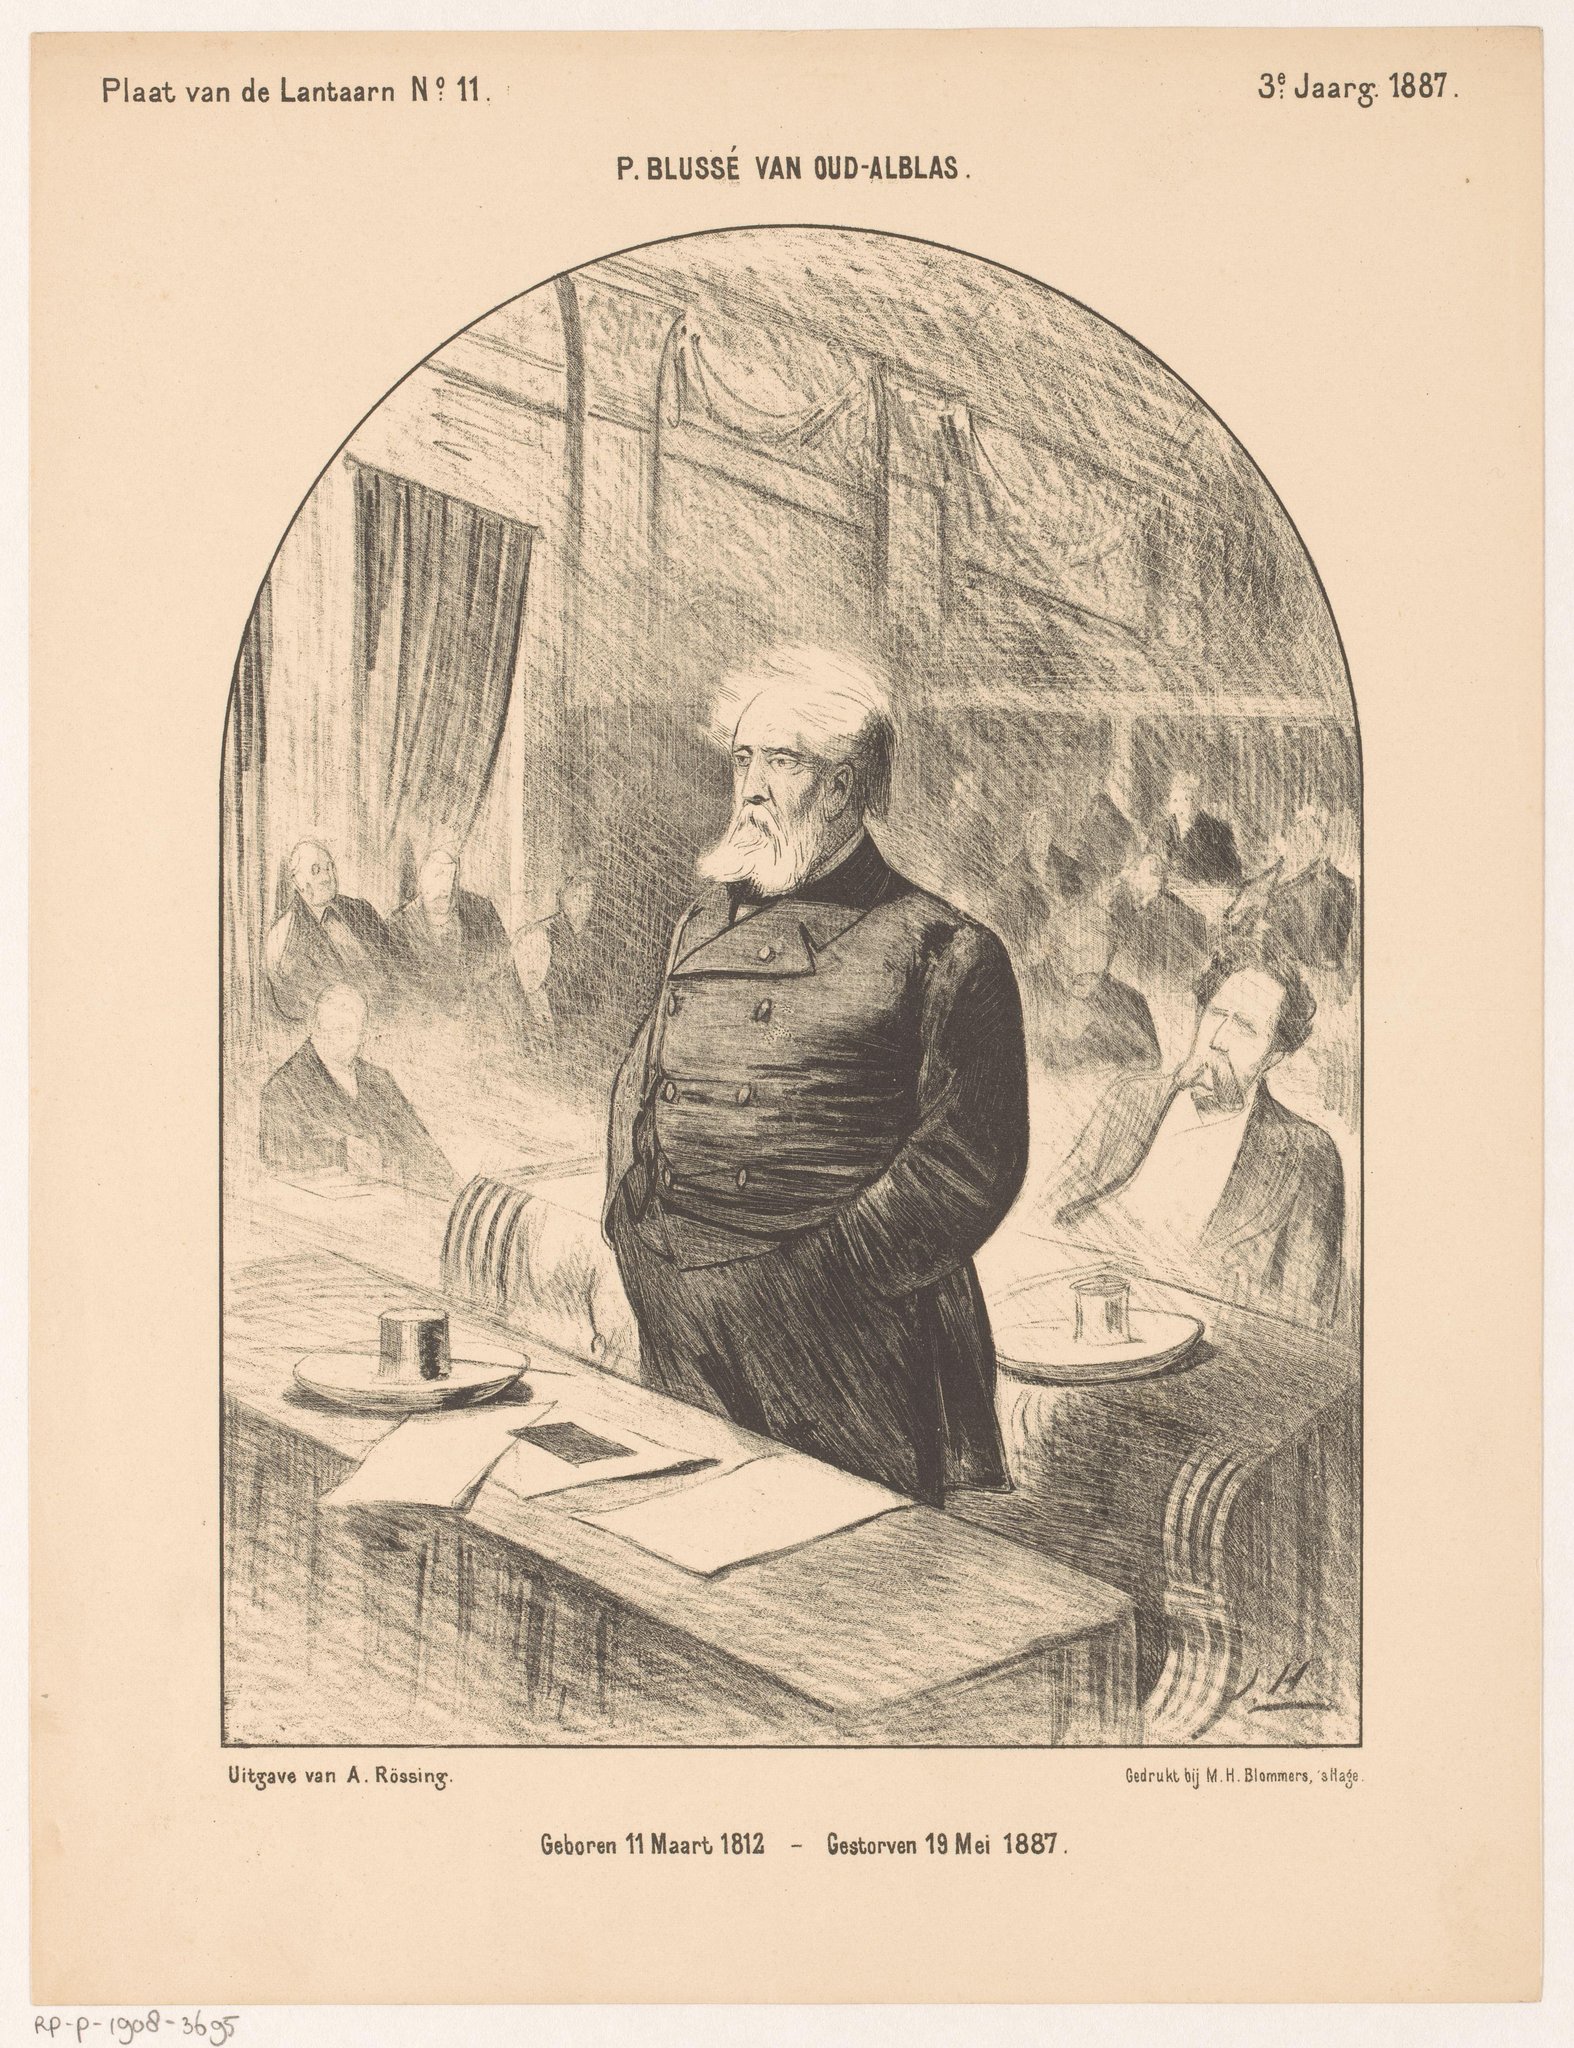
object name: cartoon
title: Portret van Pieter Blussé van Oud-Alblas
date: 1887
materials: paper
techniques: lithograph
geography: netherlands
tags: pieter blussé van oud-alblas, historical persons (+ three-quarter length portrait)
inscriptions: collector's mark: Lugt 2228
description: De geportretteerde staat te midden van de Tweede Kamer. Achter hem zitten ministers. Onder de prent zijn geboorte- en sterfdata. Deze prent werd uitgegeven bij De Lantaarn.